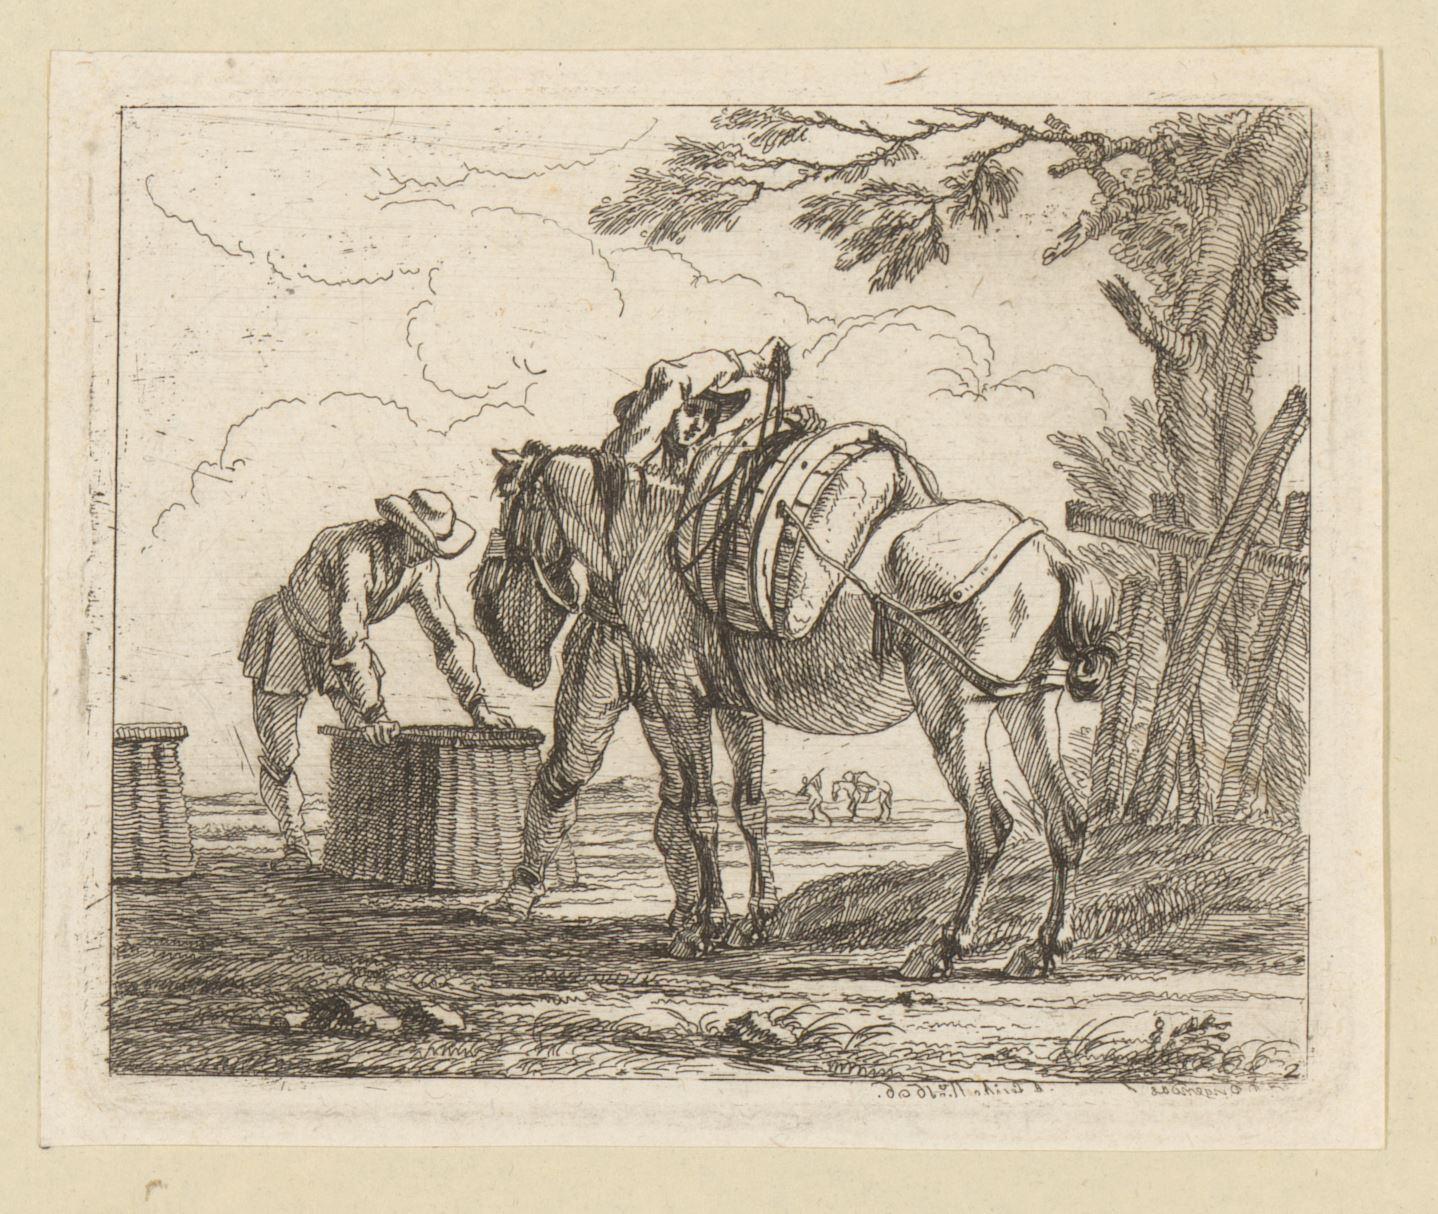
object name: print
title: Paard wordt gevoerd en afgeladen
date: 1698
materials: paper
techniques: etching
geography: augsburg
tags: riding a horse, ass, or mule; rider, horseman, pack-animal, giving water, feeding (cattle)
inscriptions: collector's mark: Lugt 240